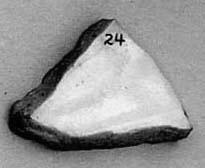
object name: fragment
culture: burmese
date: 1902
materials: jade